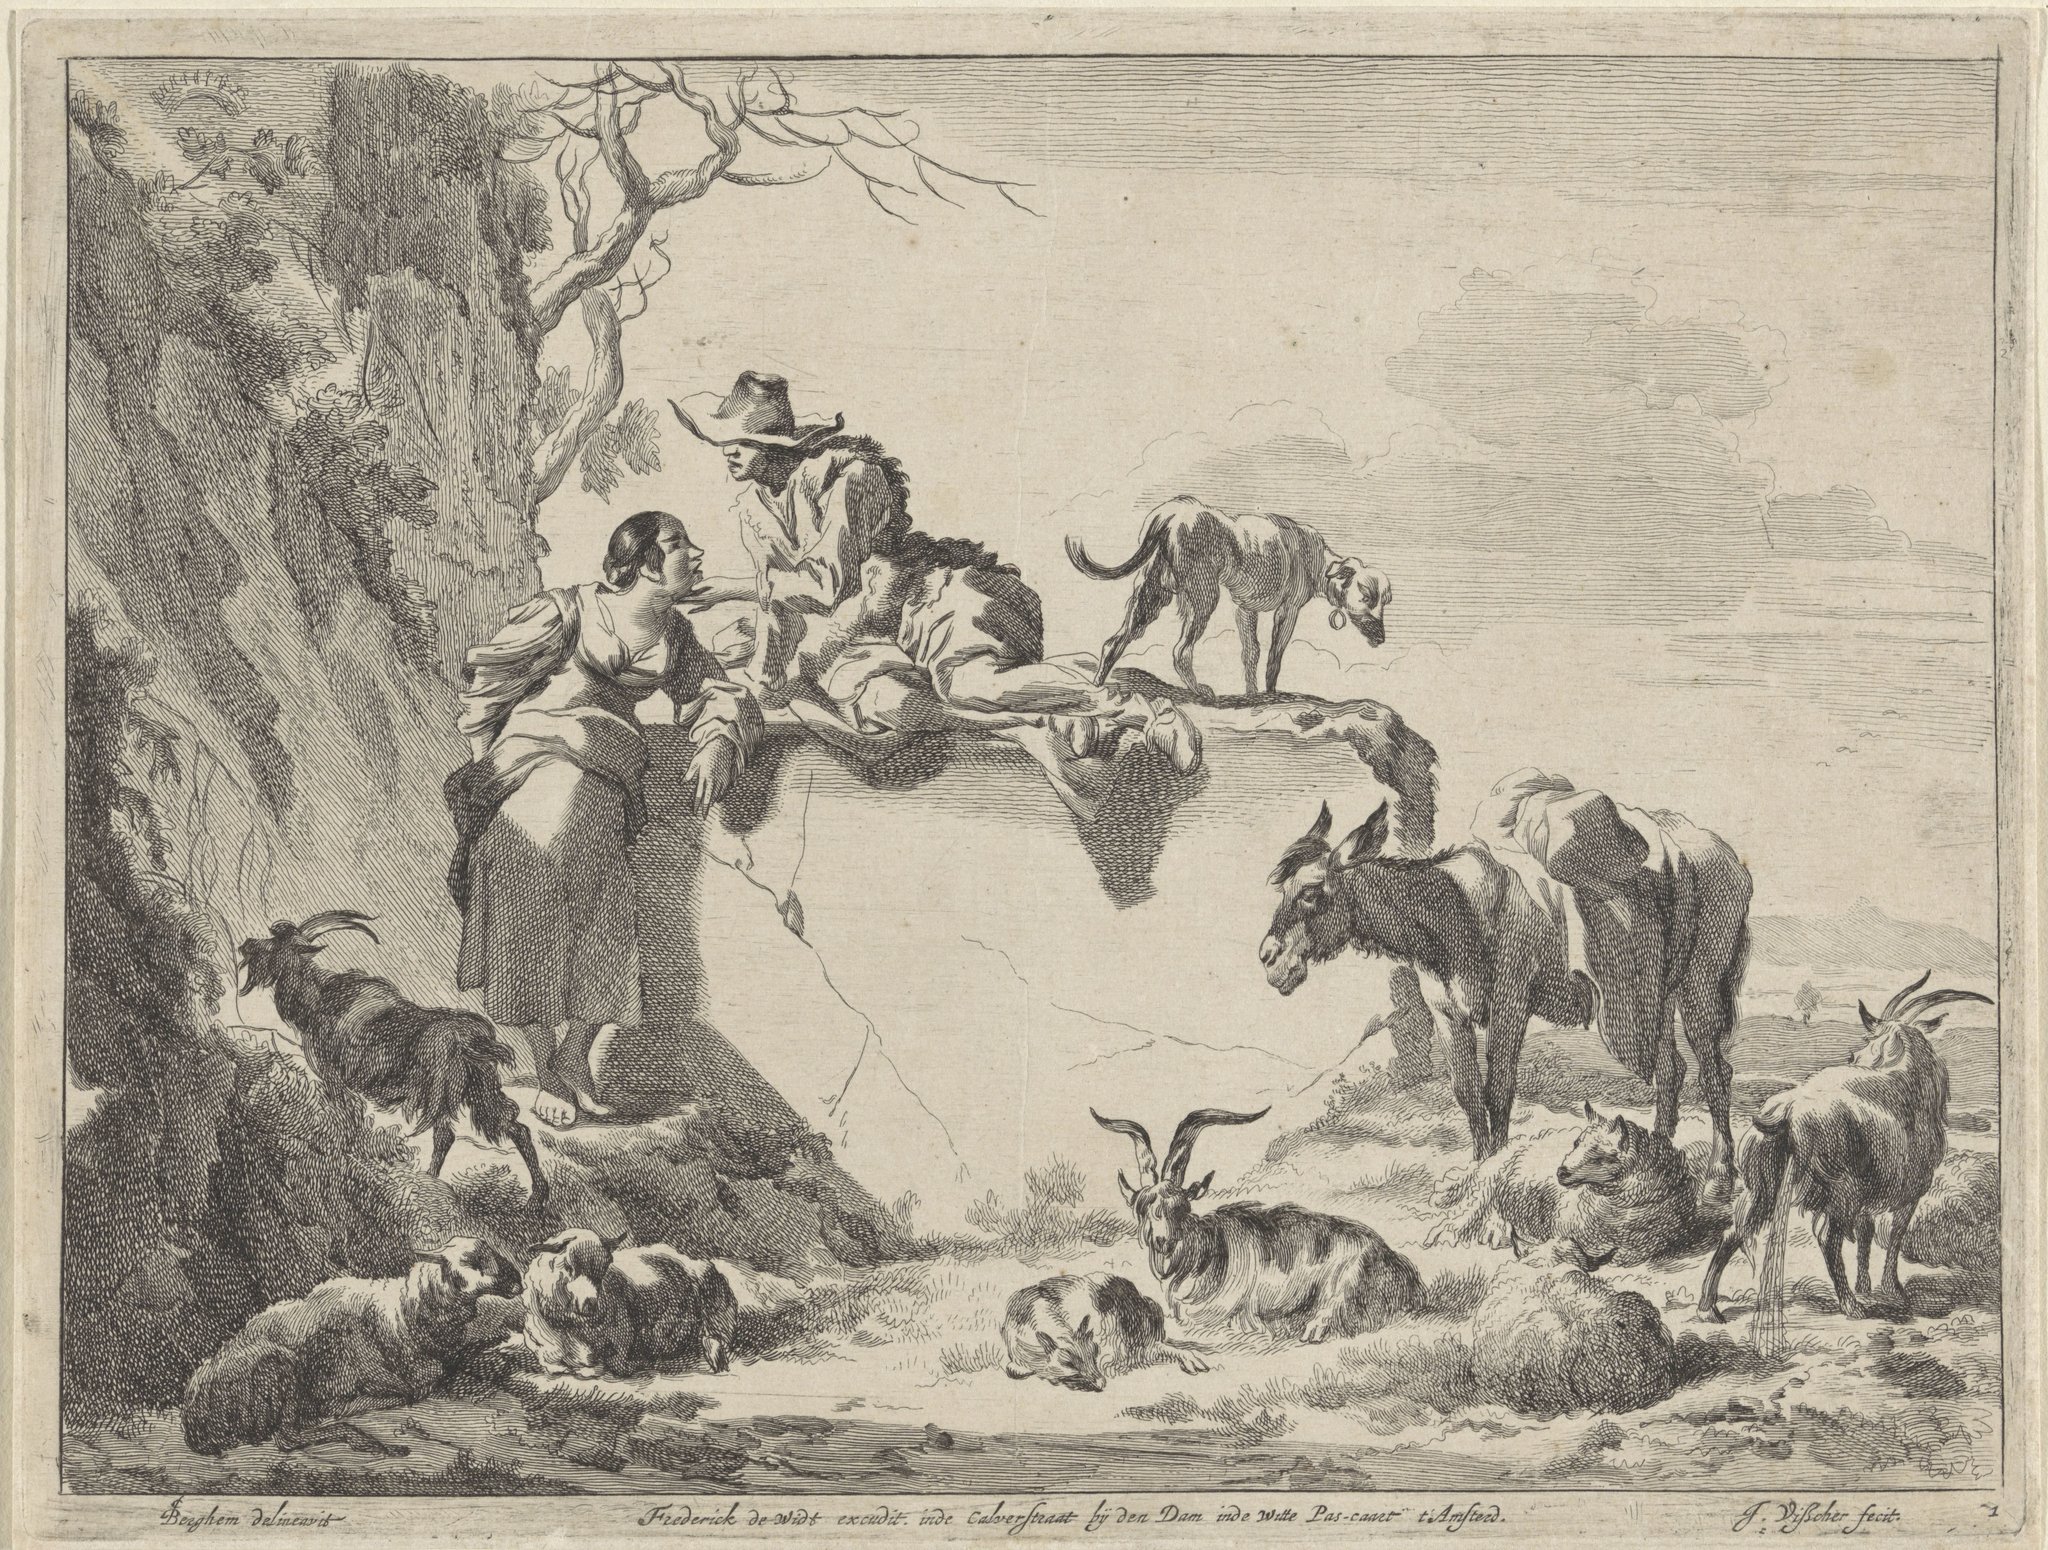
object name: print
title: Landschappen met herders en herderinnen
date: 1643-1706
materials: paper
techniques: engraving, etching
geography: amsterdam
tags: landscapes, ass, donkey, herding, herdsman, herdswoman, shepherd, shepherdess, cowherd, etc., (lovers) caressing each other, goat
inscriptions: collector's mark: Lugt 240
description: Temidden van het vee strijkt een herder, vanaf de steen waarop hij zit, de wang van de herderin die voor hem staat. Naast de herder staat een hond.